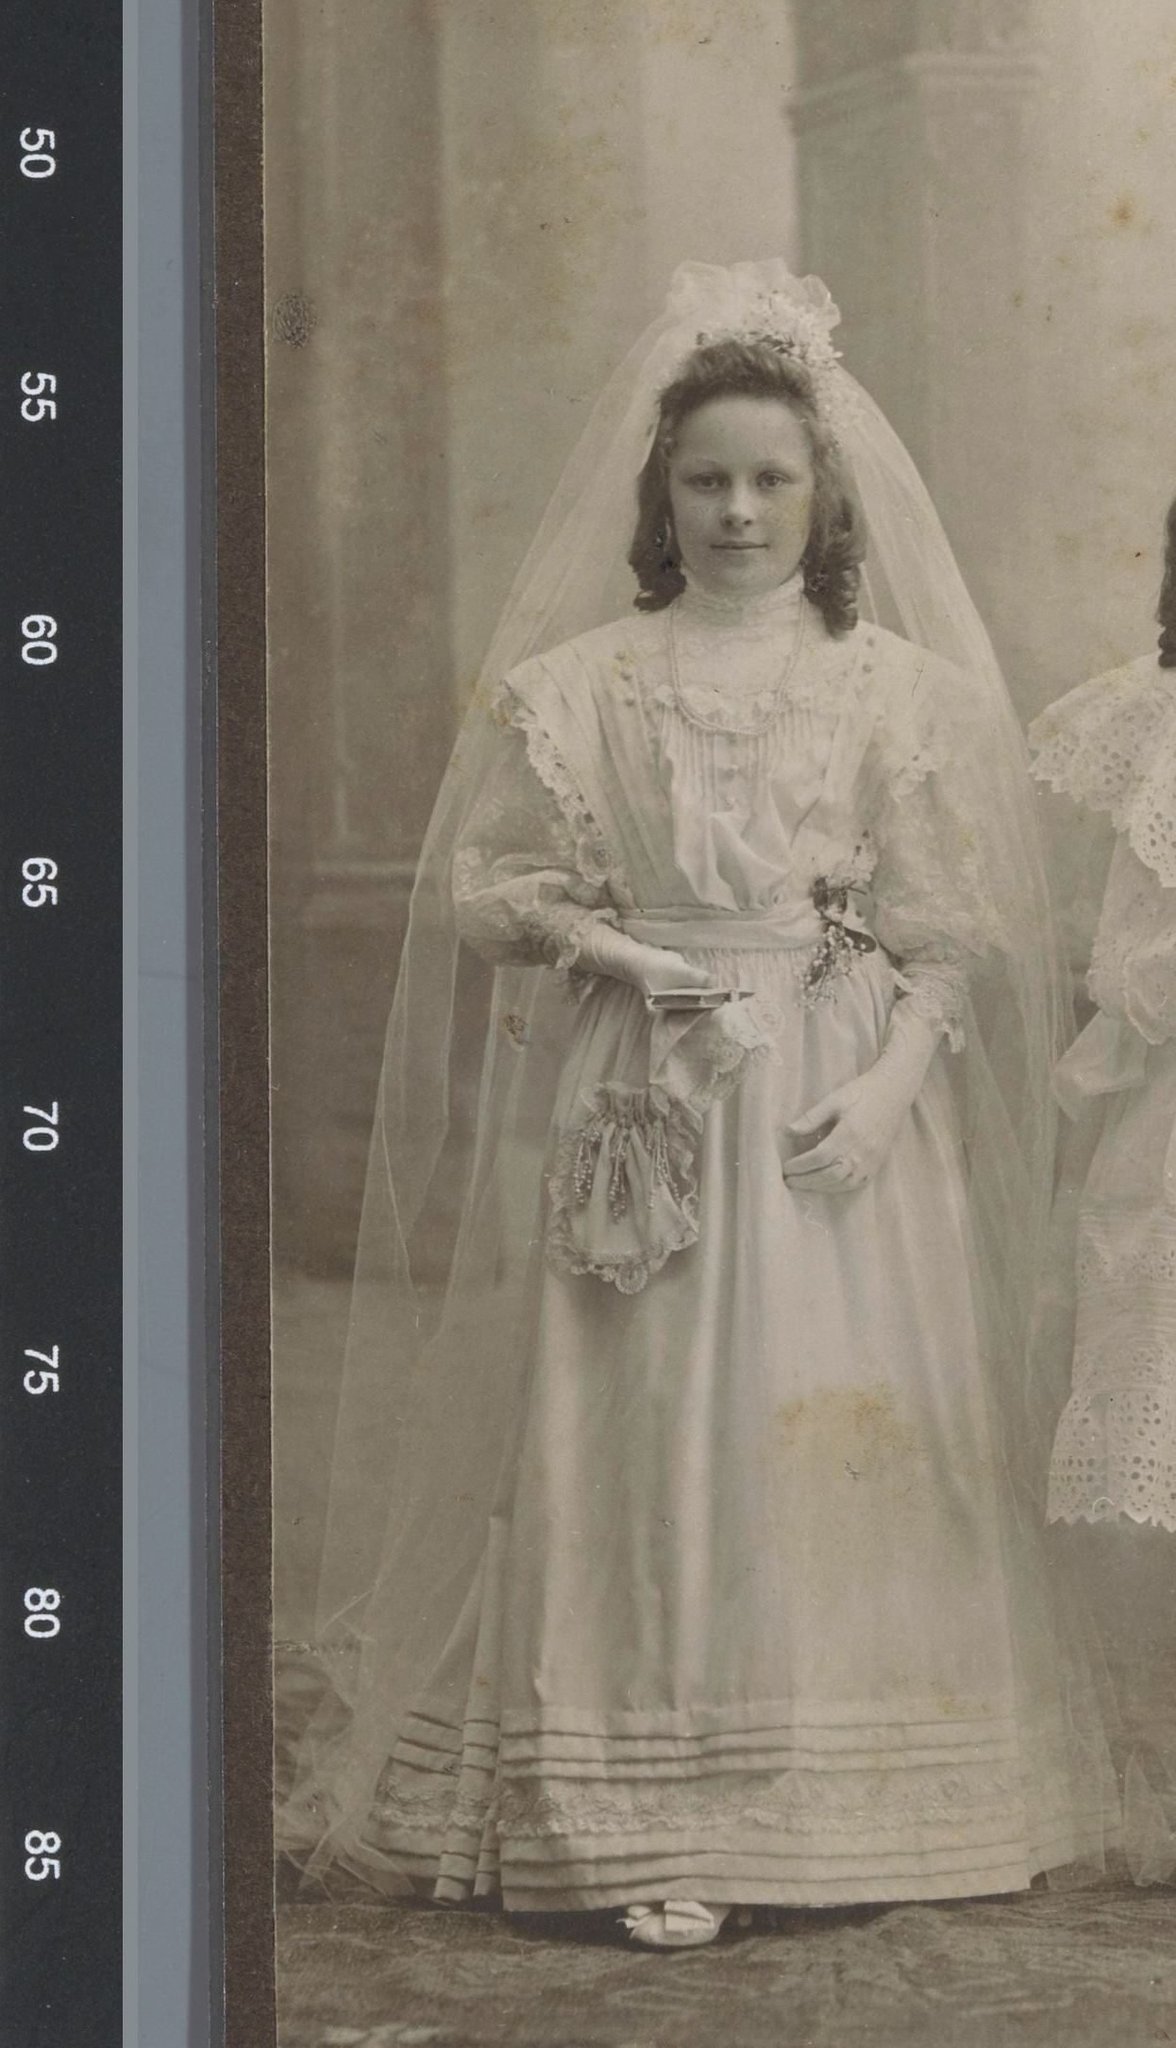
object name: carte de visite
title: Portret van twee onbekende meisjes in witte kleding voor hun eerste communie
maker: alex bratsch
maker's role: fotograaf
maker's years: 1869-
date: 1901-1914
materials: paper, cardboard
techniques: gelatin silver print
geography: amsterdam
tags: communion dress, girl (child between toddler and youth), anonymous historical person portrayed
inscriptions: address: ‘AMSTERDAM/ STADHOUDERSKADE 82’